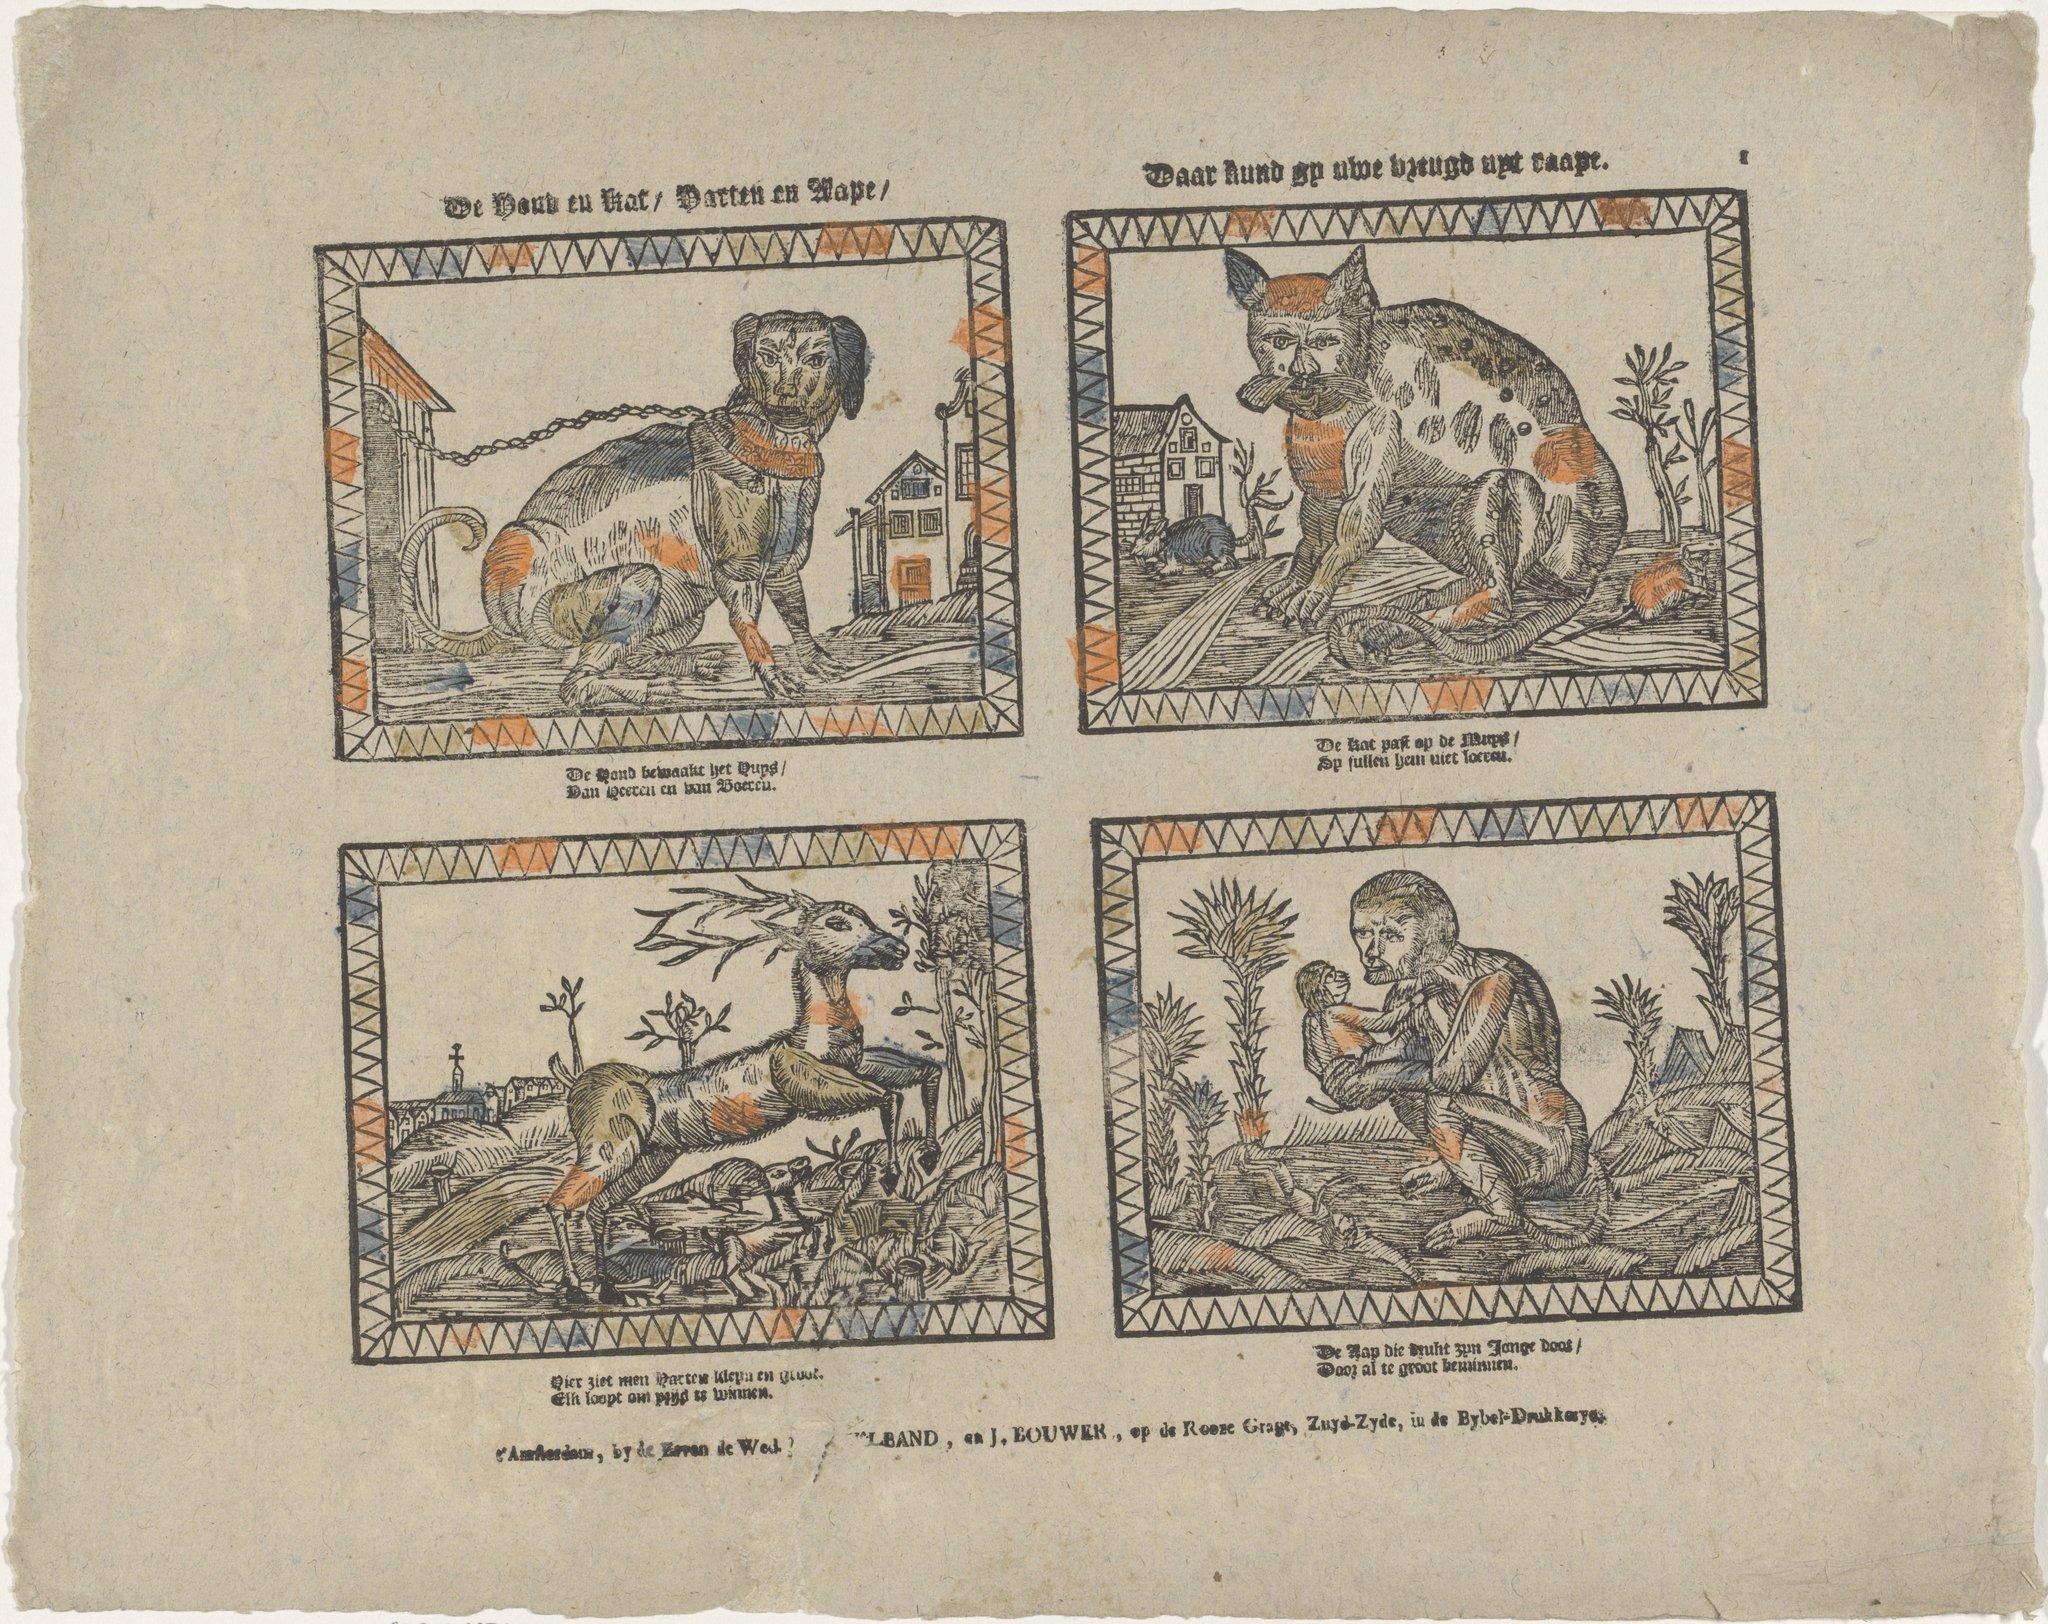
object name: print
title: De hond en kat / harten en aape / Daar kund gy uwe breugd uyt raape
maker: Anonymous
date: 1760-1767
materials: paper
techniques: colour, letterpress printing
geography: amsterdam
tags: hoofed animals: deer, animals, cat, monkeys, apes, dog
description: Blad met 4 voorstellingen van dieren: een hond, een kat, een hert en een aap. Onder elke afbeelding een tweeregelig vers. Genummerd rechtsboven: 1.